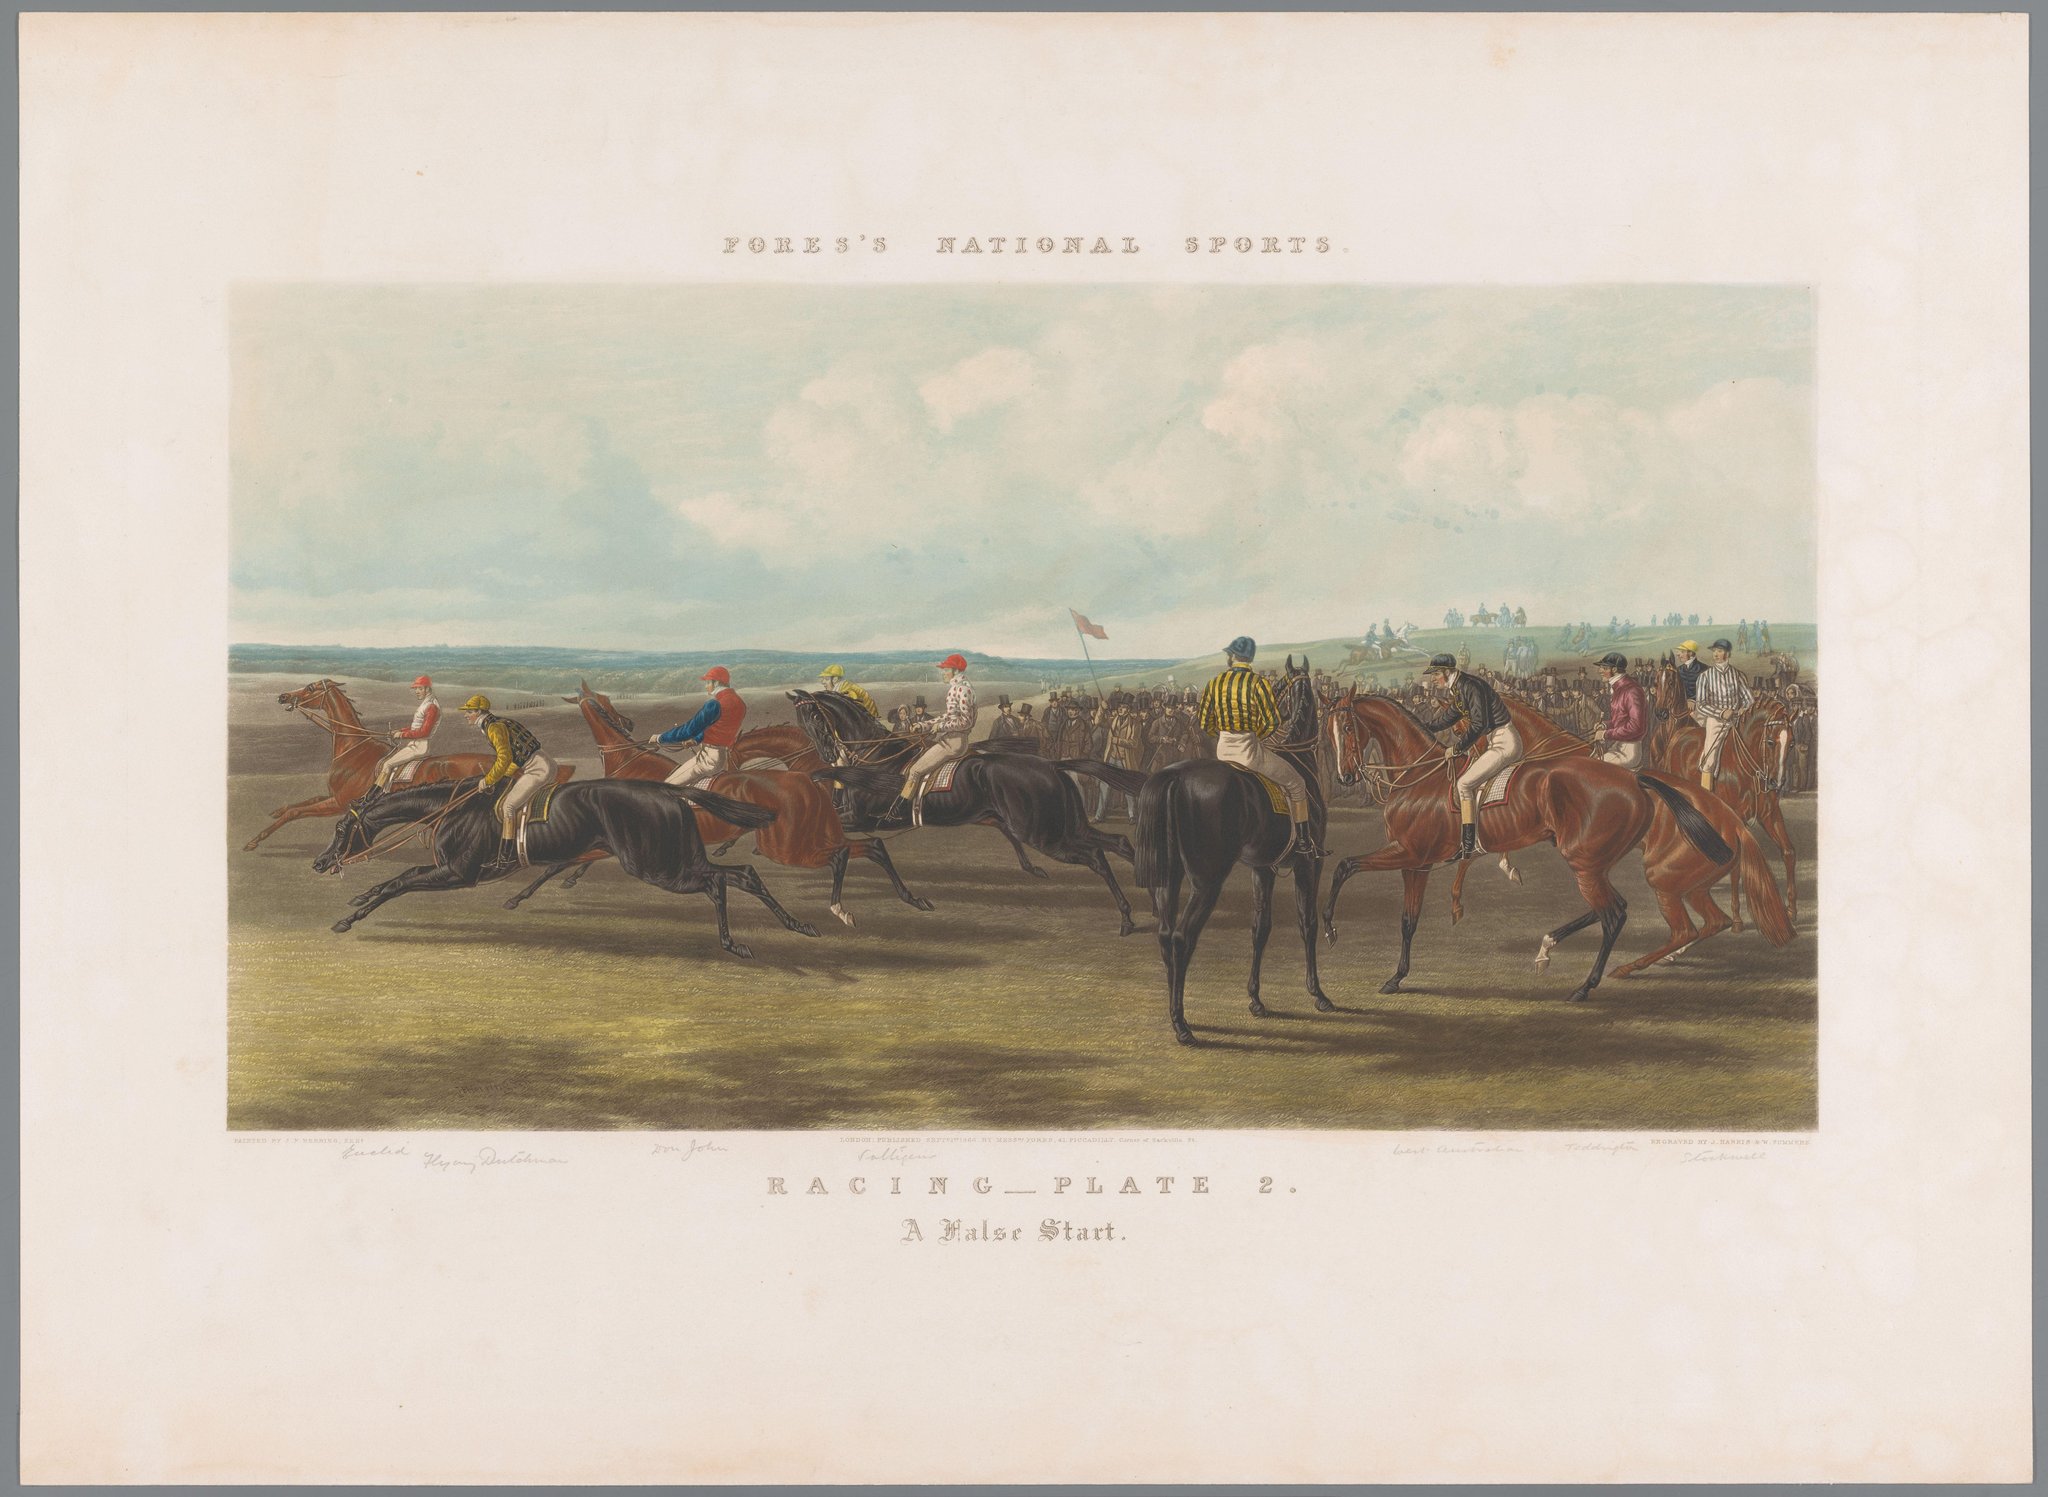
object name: print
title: Racing - Plate 2. A False Start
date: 1866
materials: paper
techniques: aquatint, etching, hand coloring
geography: london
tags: horse-racing, race-track, england